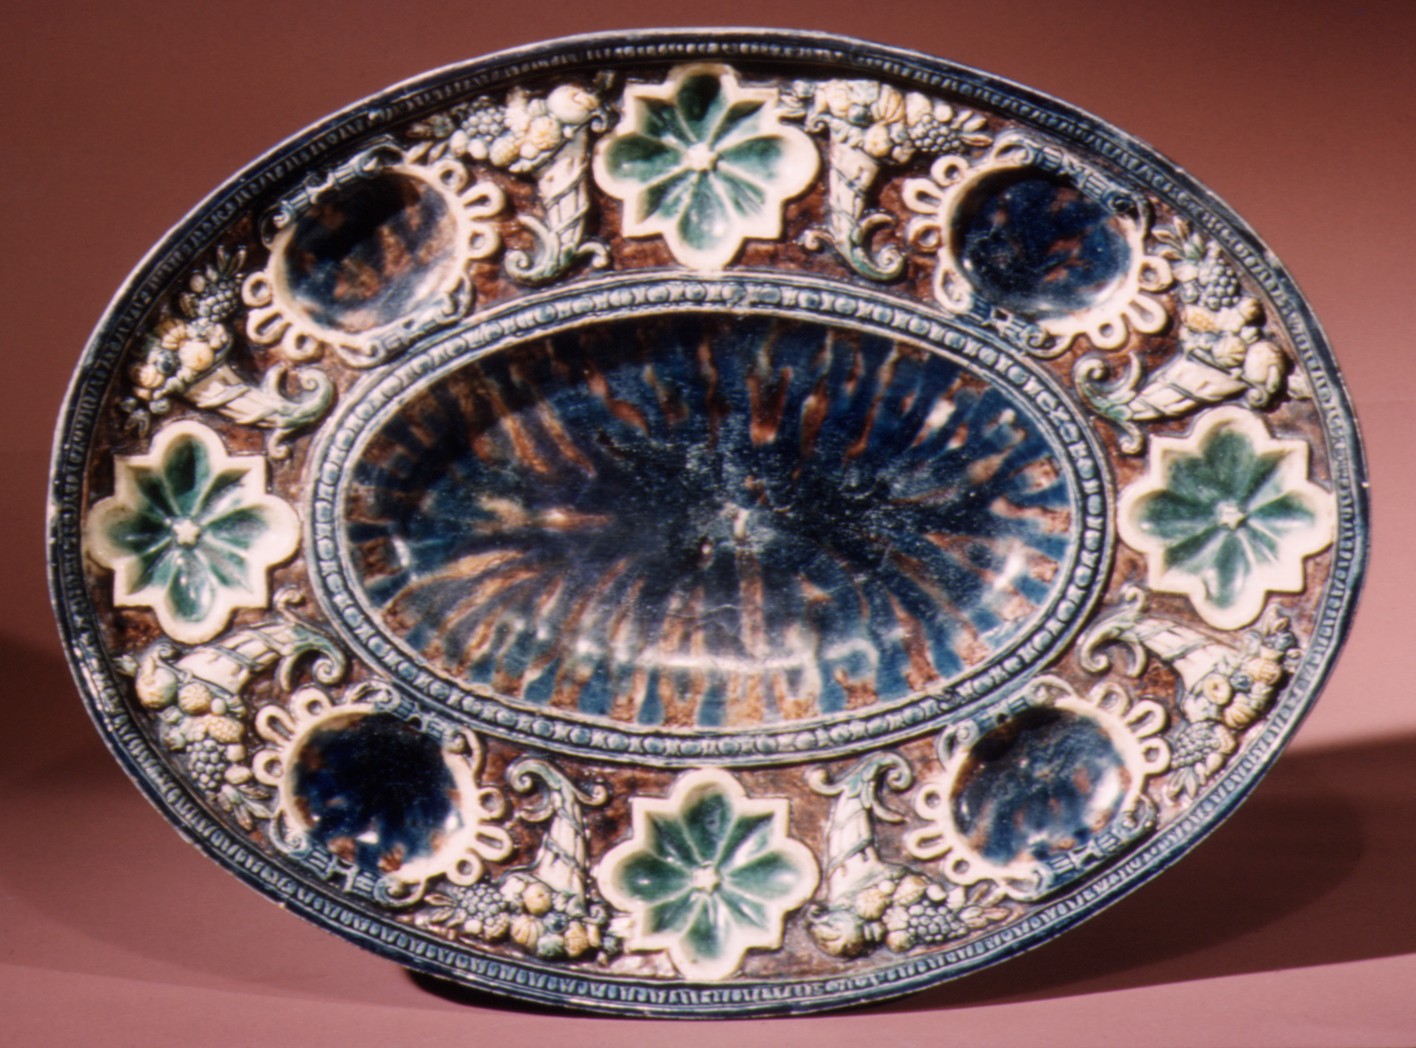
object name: dish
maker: bernard palissy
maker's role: maker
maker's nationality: french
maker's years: 1510-1590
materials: earthenware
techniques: glazing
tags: cornucopia